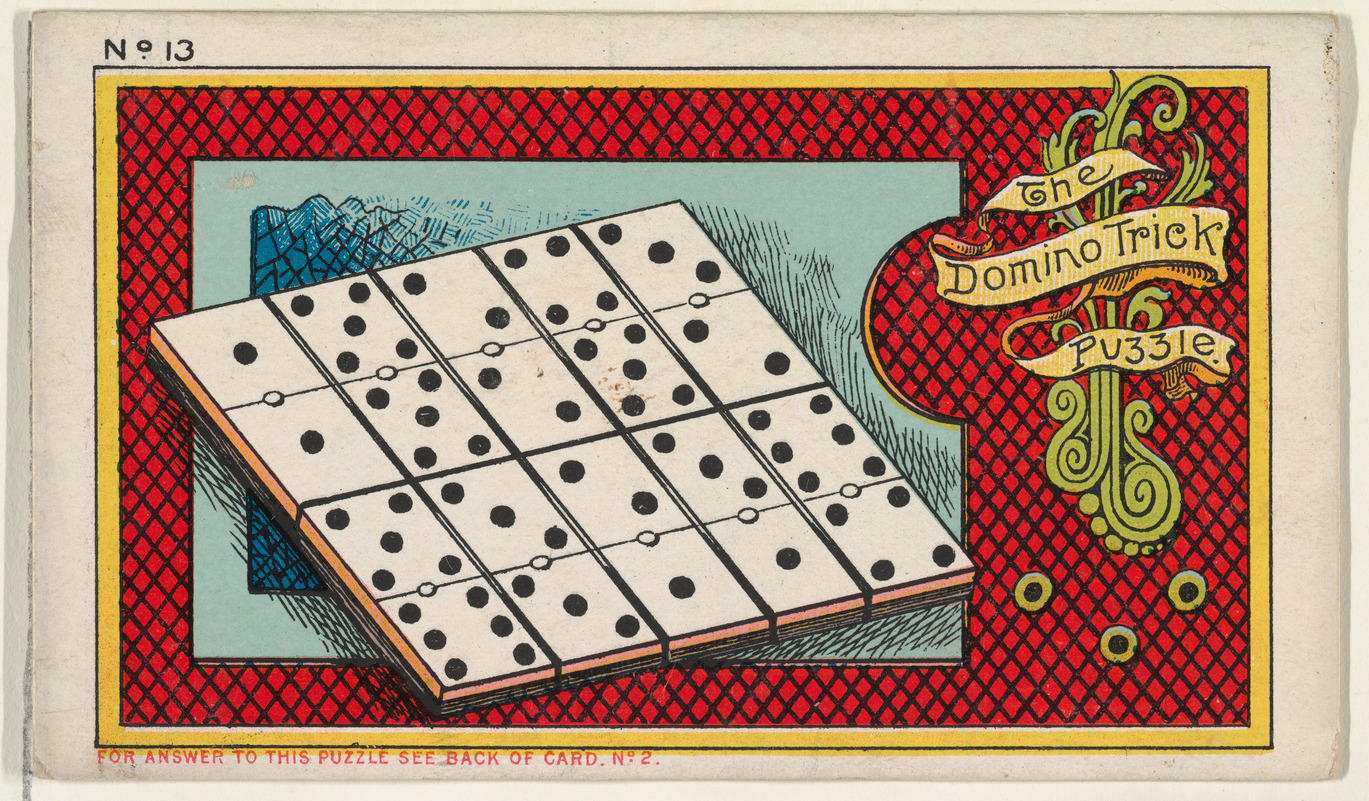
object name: print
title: Puzzle Card Number 13, The Domino Trick Puzzle, from the Jokes series (N118) issued by Duke Sons & Co. to promote Honest Long Cut Tobacco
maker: w. duke, sons & co.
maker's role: publisher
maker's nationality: american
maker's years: 1870-1920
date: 1890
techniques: color lithograph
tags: games